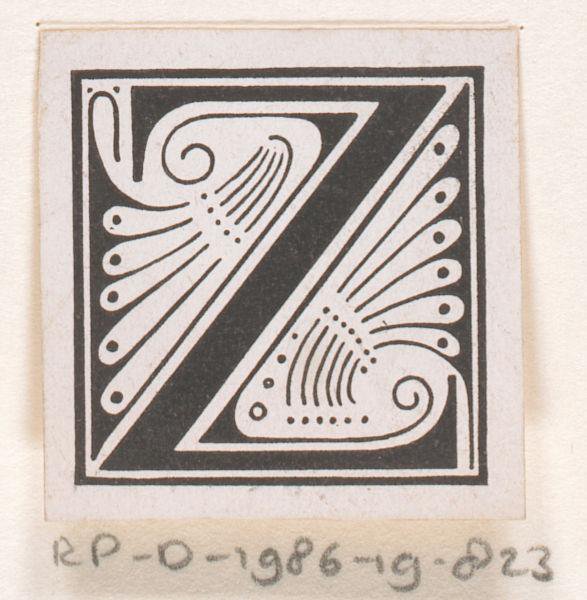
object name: photomechanical print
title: Initiaal Z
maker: reinier willem petrus de vries (1874-1953)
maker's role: draughtsman, print maker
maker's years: 1874-1953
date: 1904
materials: paper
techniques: printing block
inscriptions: collector's mark: ‘R:MVS.’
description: Het initiaal is gebruikt voor: Veth, Jan. Jozef Israëls en zijn kunst. Arnhem en Nijmegen: Gebroeders E&M Cohen, 1904.